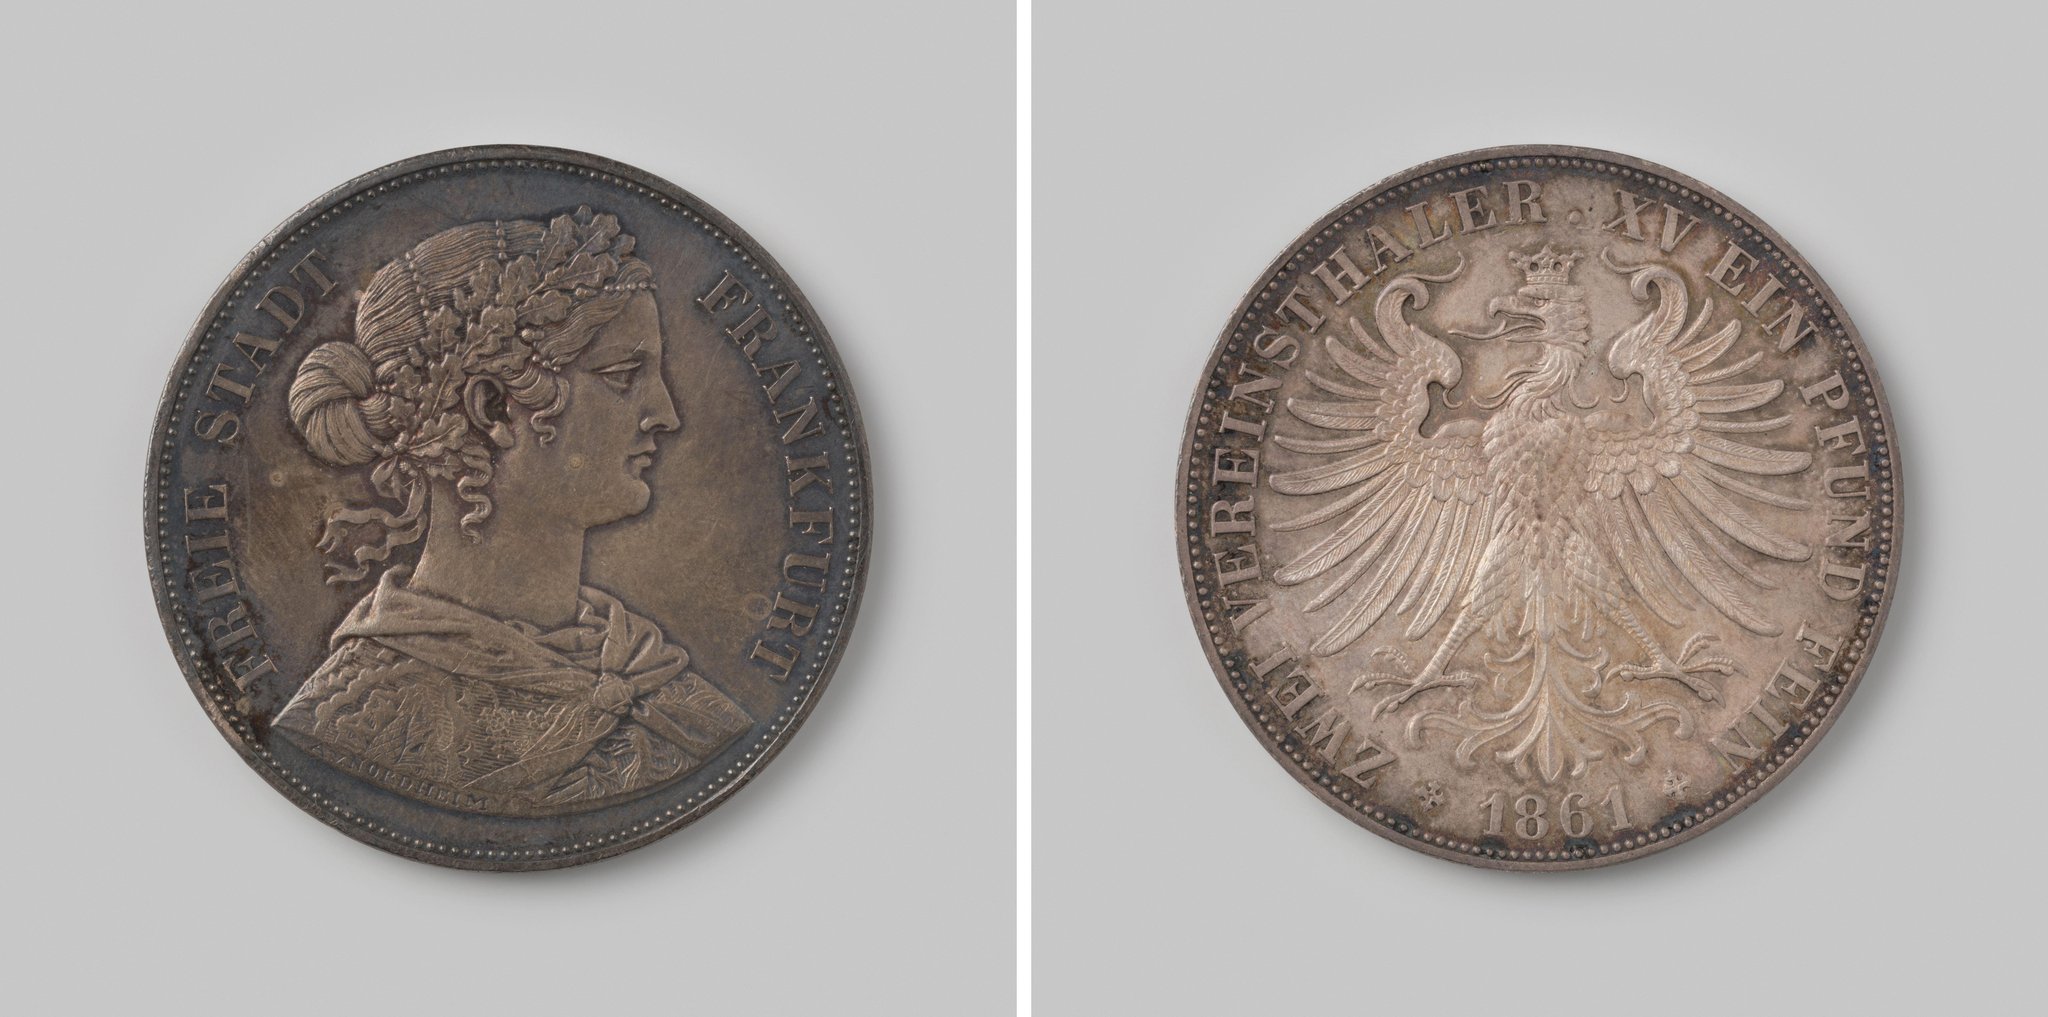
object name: twee vereinstaler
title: Vrije rijksstad Frankfurt am Main, 2 vereinstaler, 1861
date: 1861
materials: silver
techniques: striking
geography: frankfurt am main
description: Zilveren munt. Voorzijde: portret van een vrouw naar rechts. Keerzijde: gekroonde enkelkoppige adelaar. Waarde-aanduiding: Zwei Vereinsthaler in omschrift met onderaan jaartal. Randschrift.